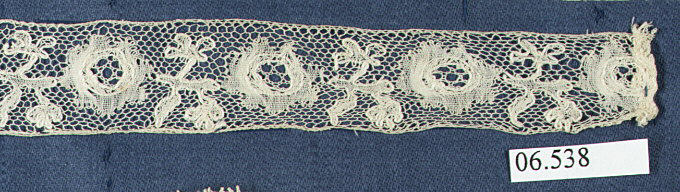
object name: fragment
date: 1810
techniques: lace